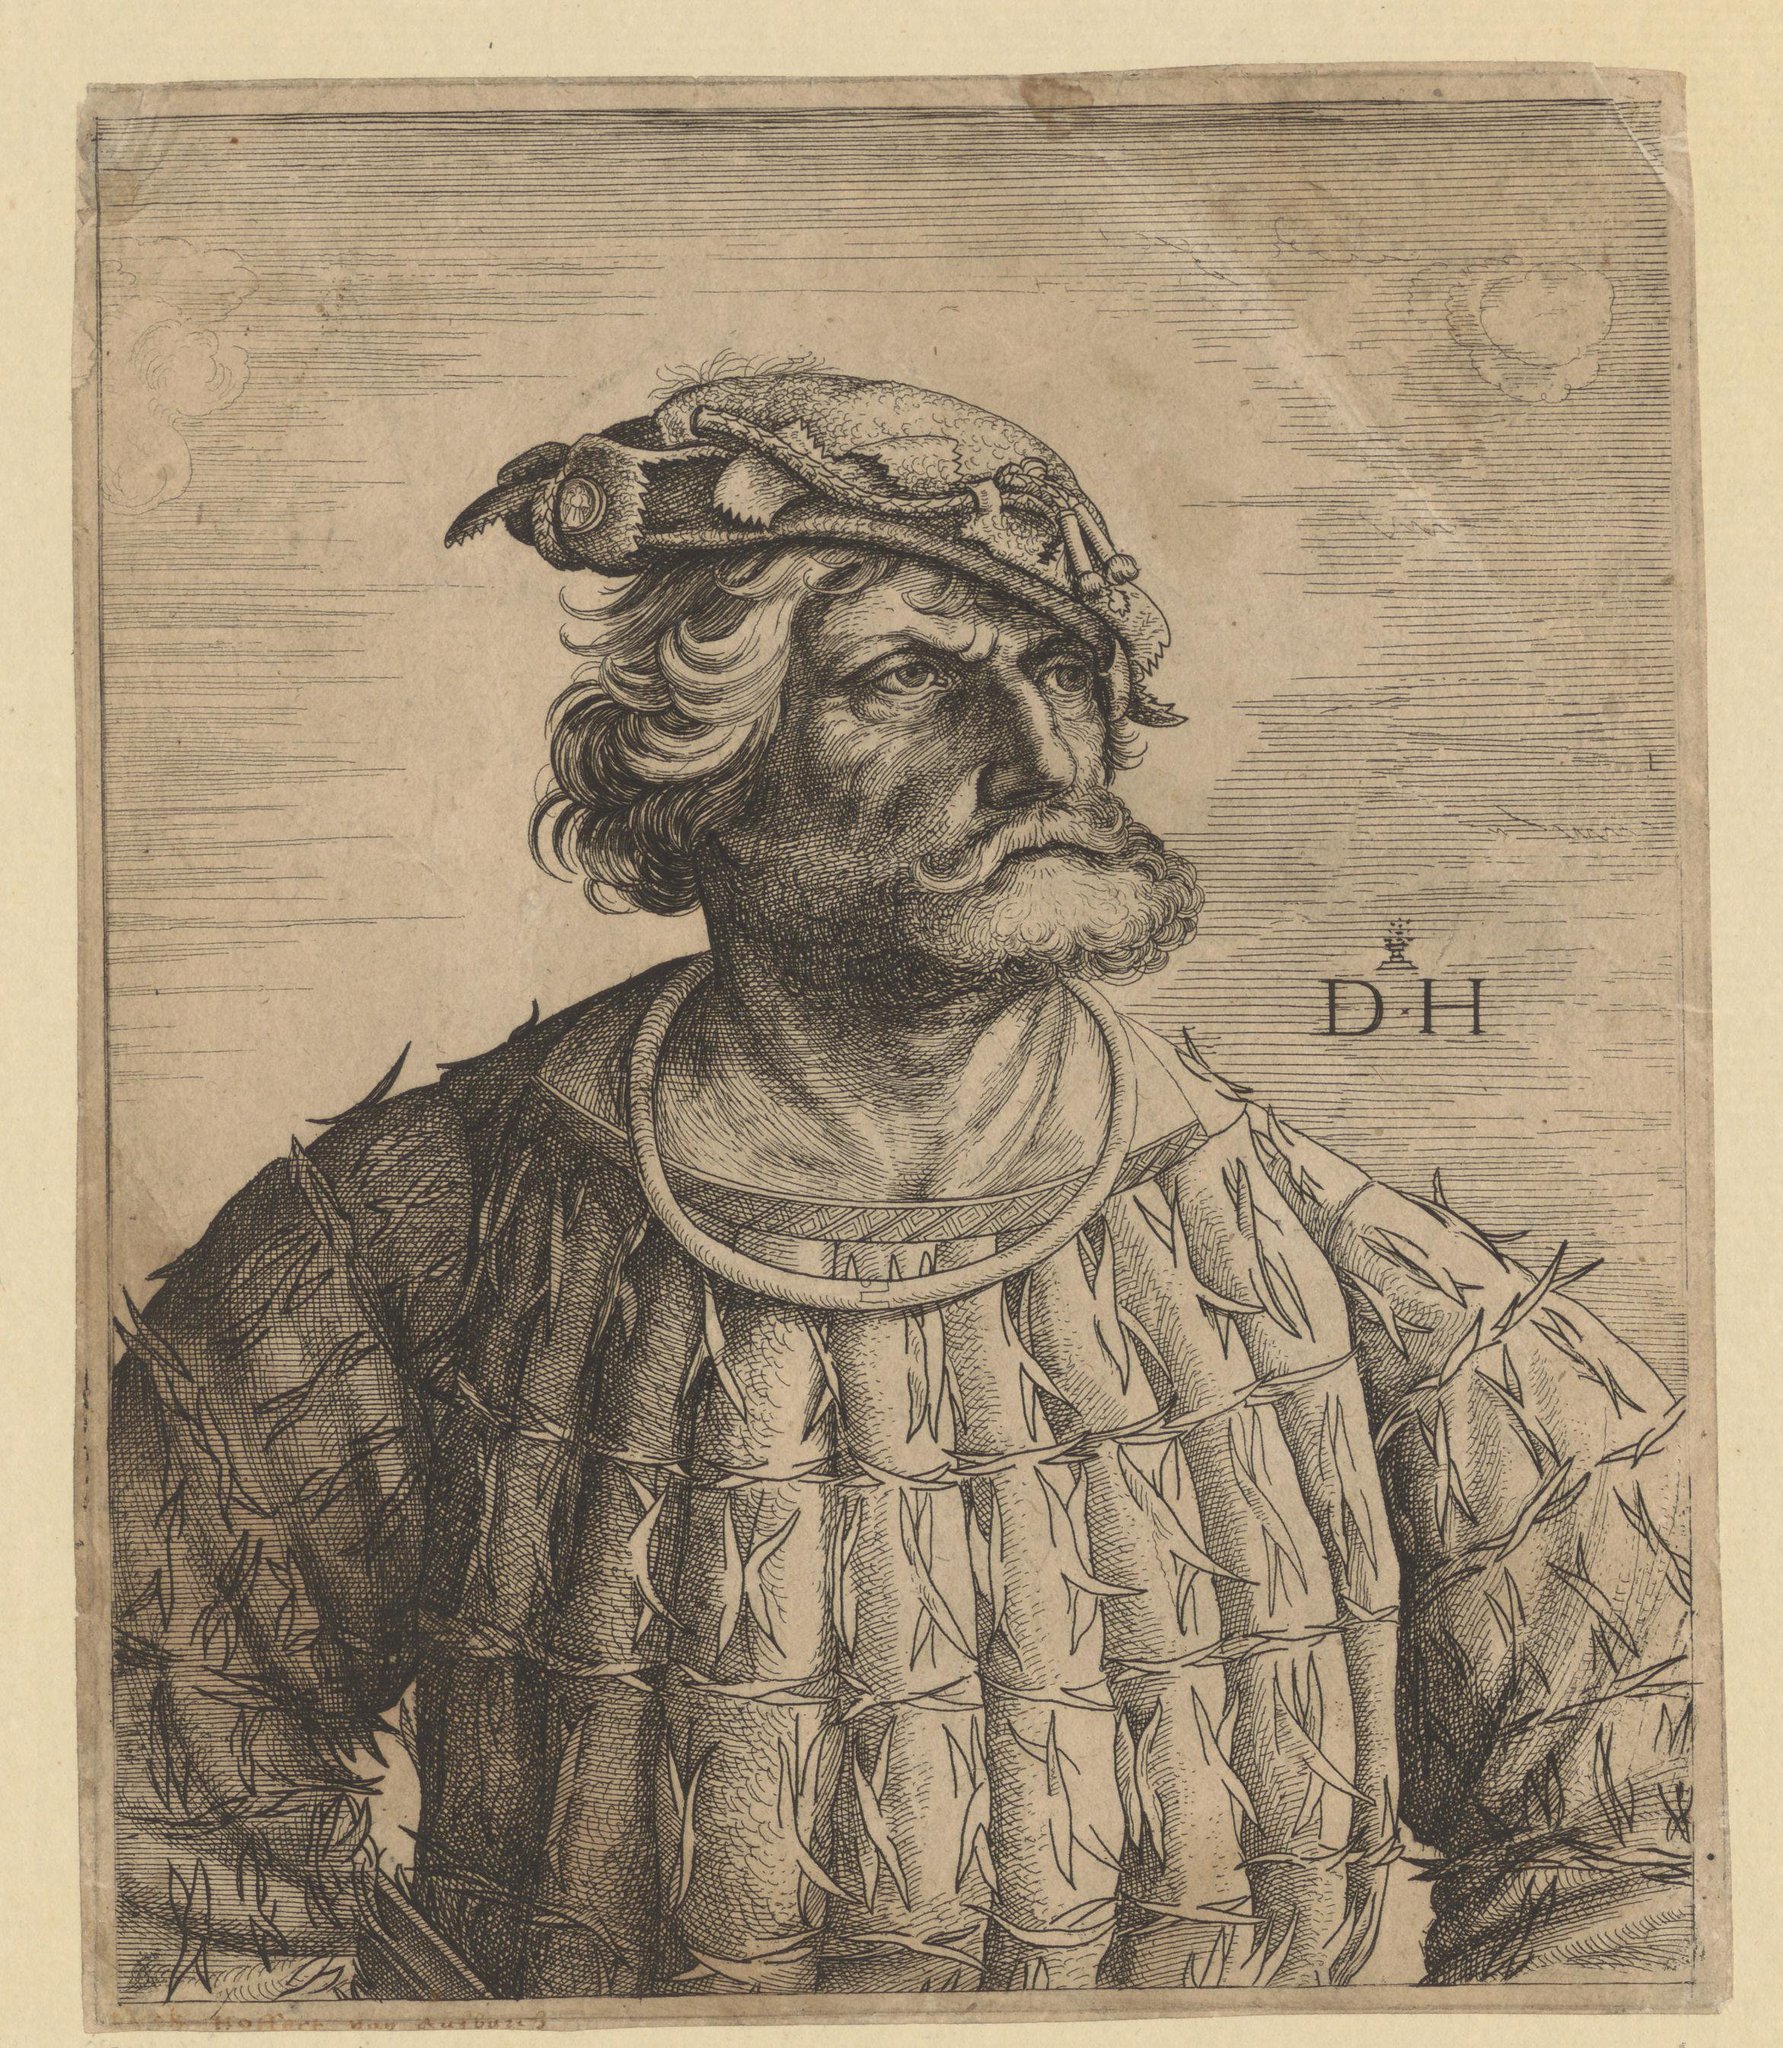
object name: print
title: Portret van Kunz von der Rosen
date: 1490-1586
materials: paper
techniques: etching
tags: court jester, court fool, historical persons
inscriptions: collector's mark: Lugt 240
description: Kopie in spiegelbeeld van detail van het portret van Kunz von der Rosen door Daniel Hopfer, aanwezig in collectie van het RMA: RP-P-OB-49.935.